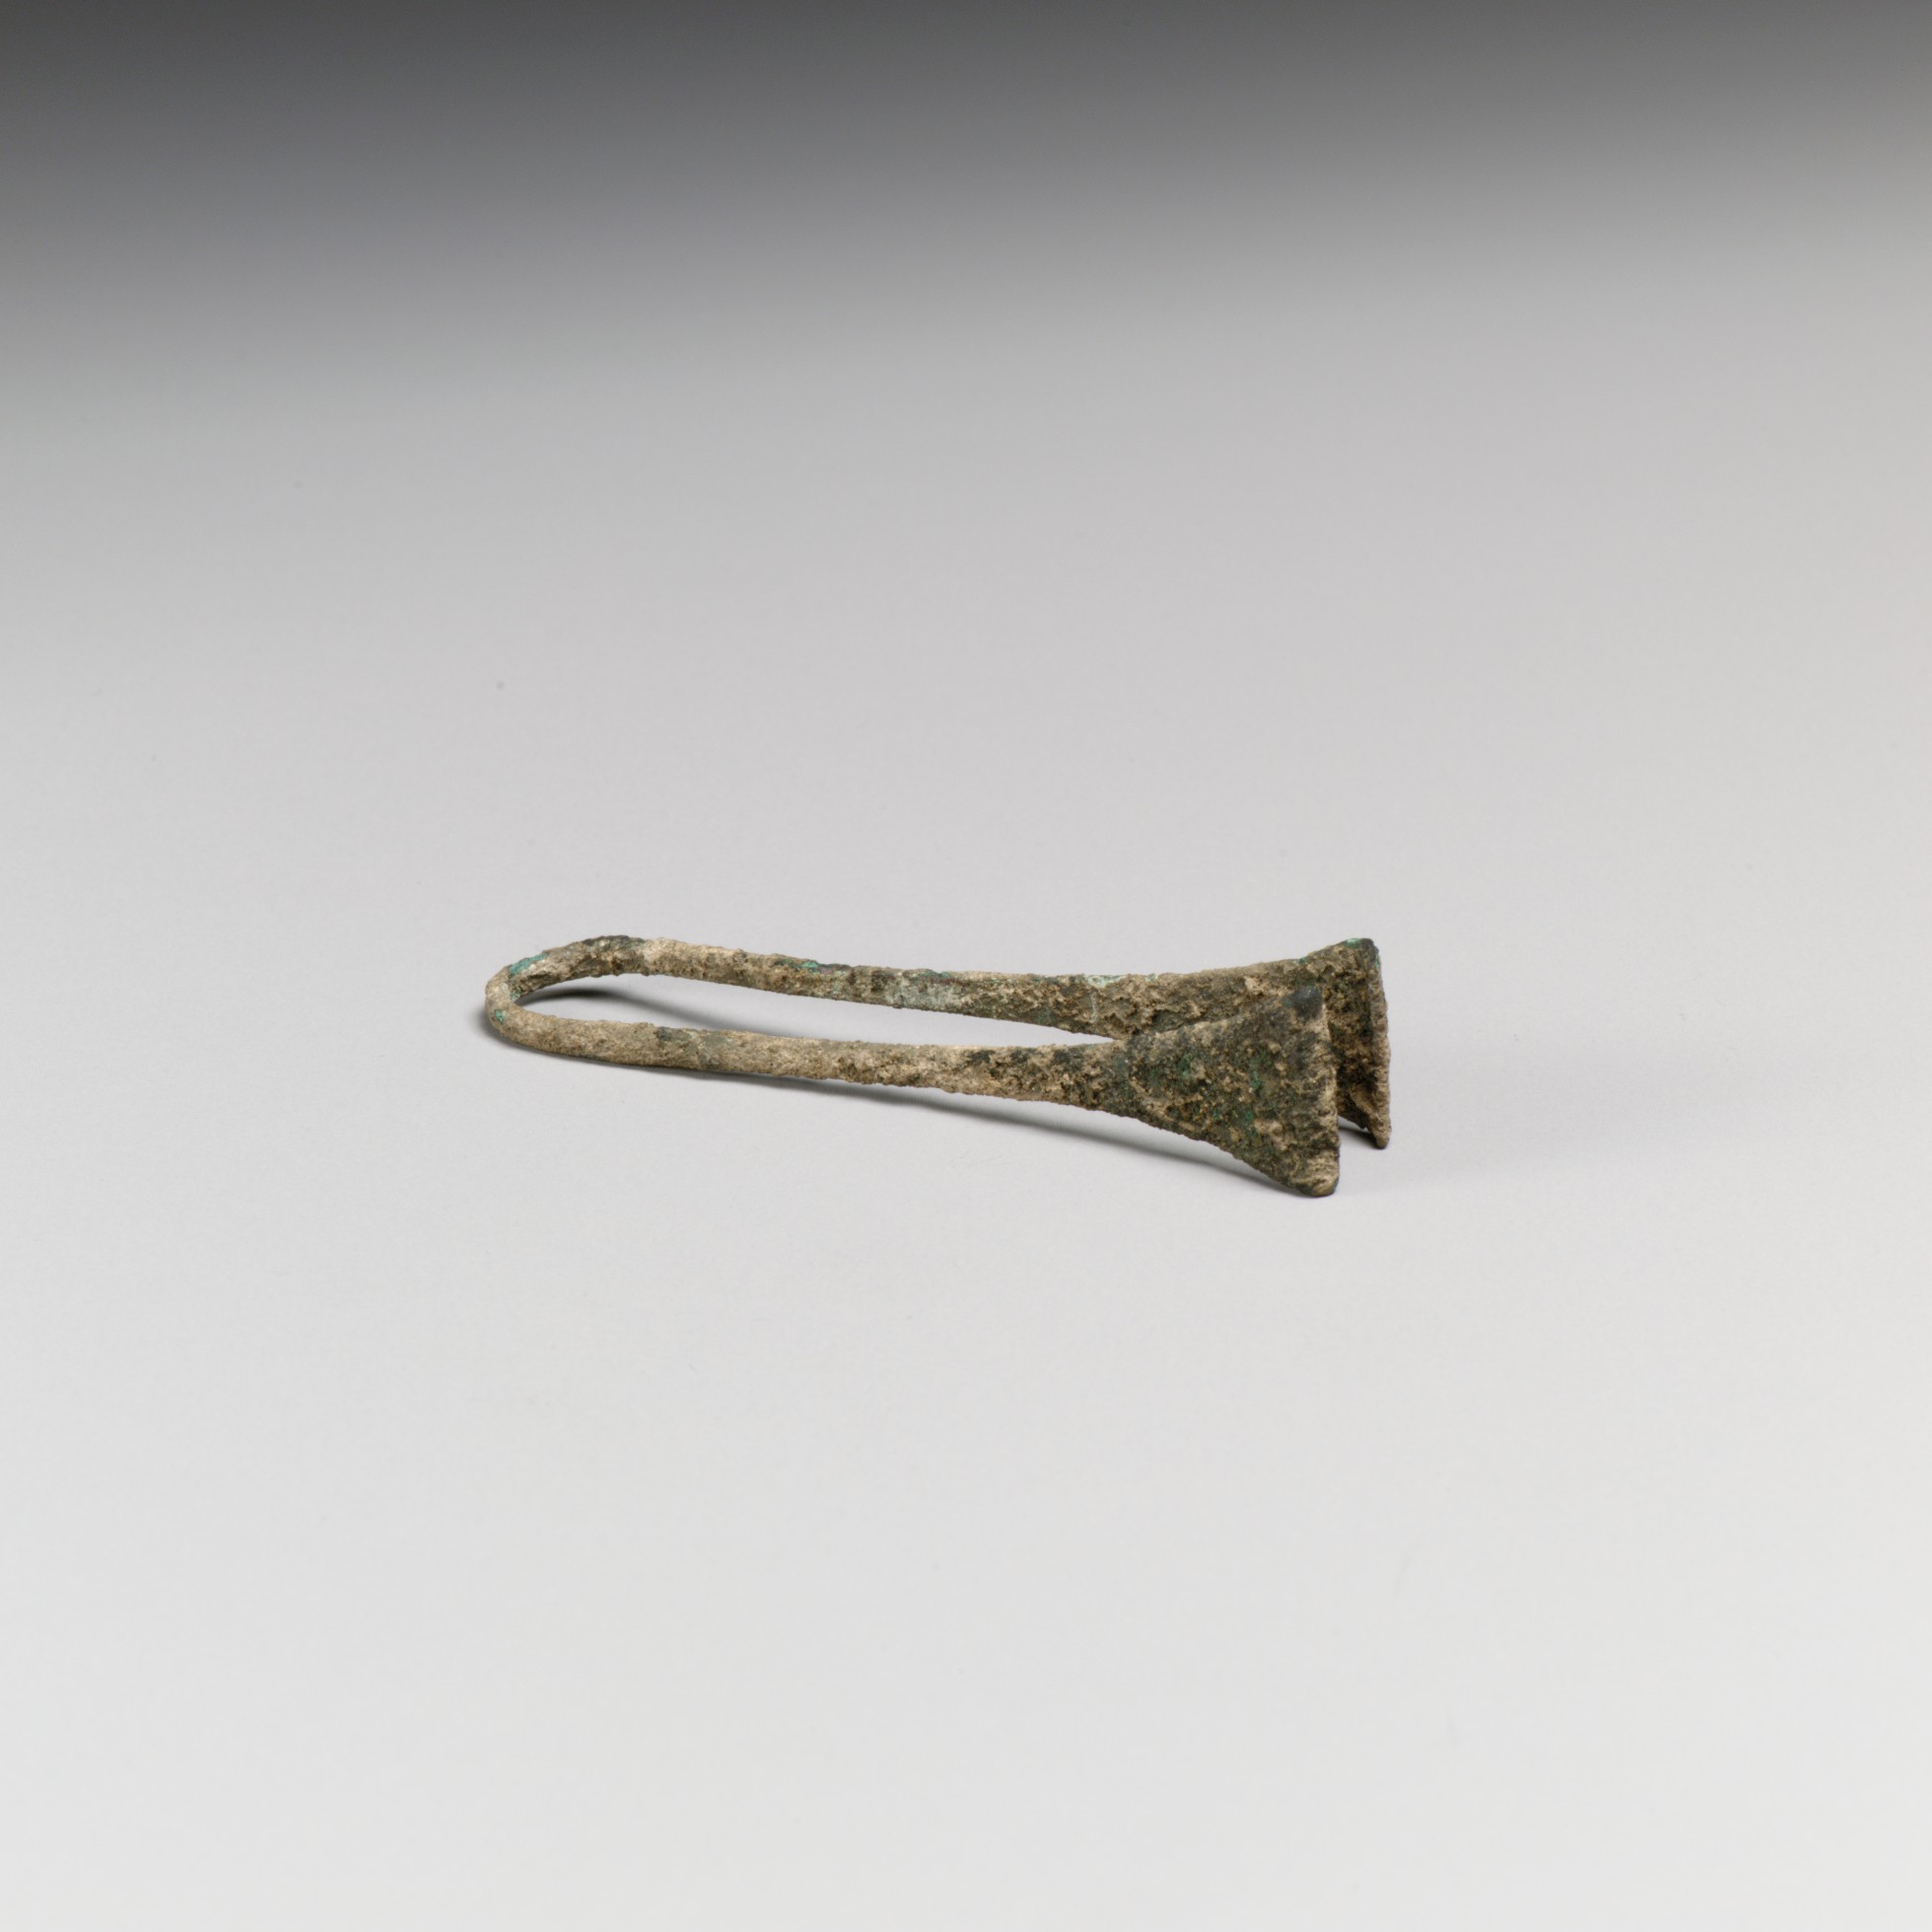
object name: tweezer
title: Bronze tweezers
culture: minoan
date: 2900-1050 BCE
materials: bronze